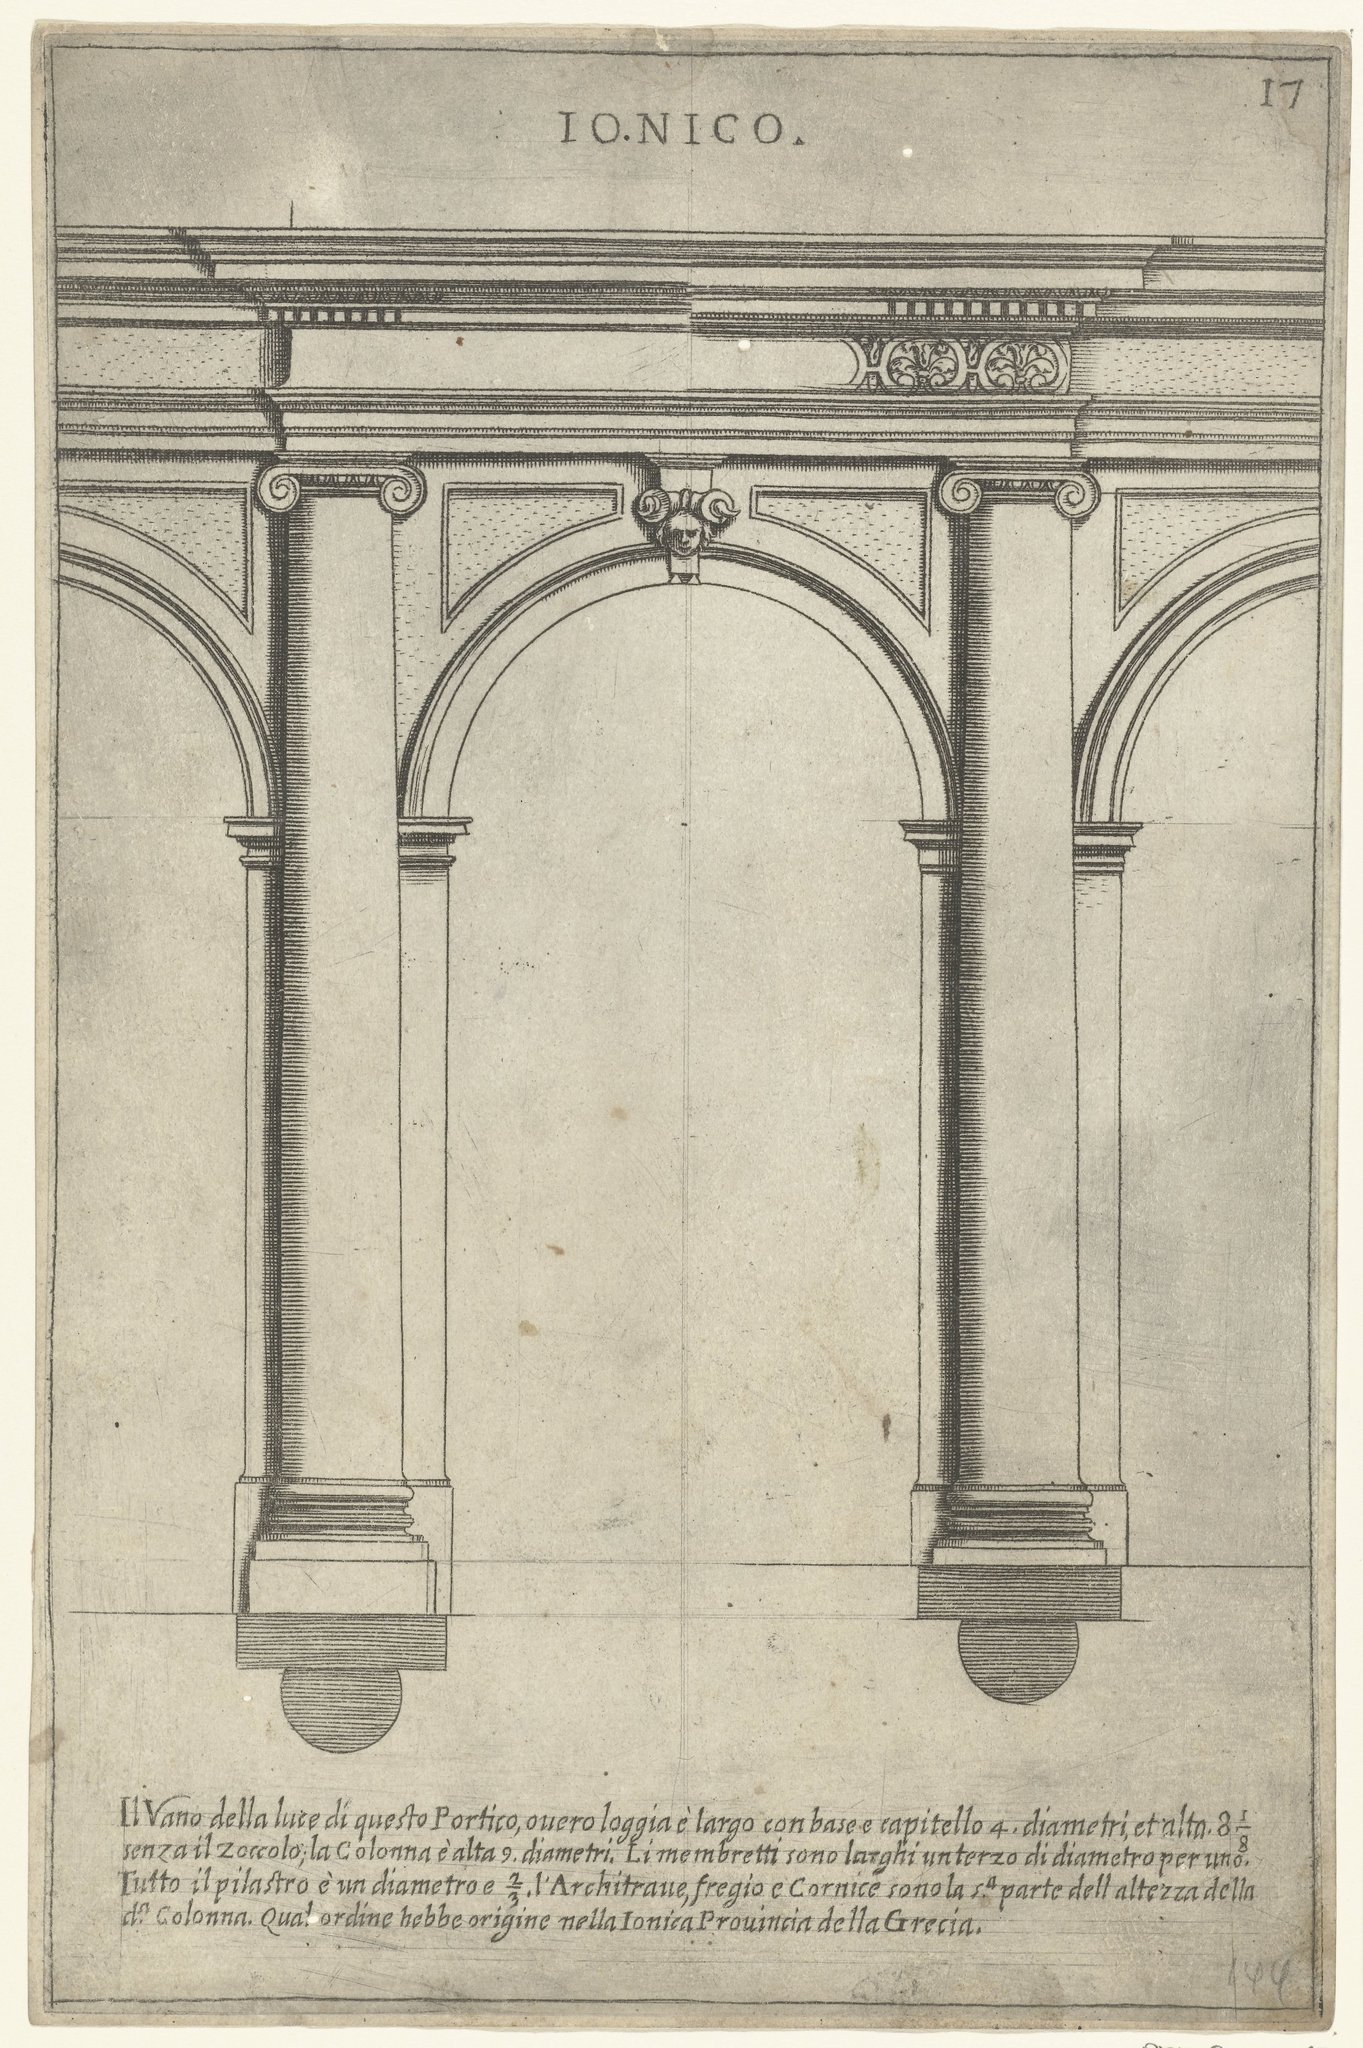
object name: ornament print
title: Ionische portiek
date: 1636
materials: paper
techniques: engraving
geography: italy